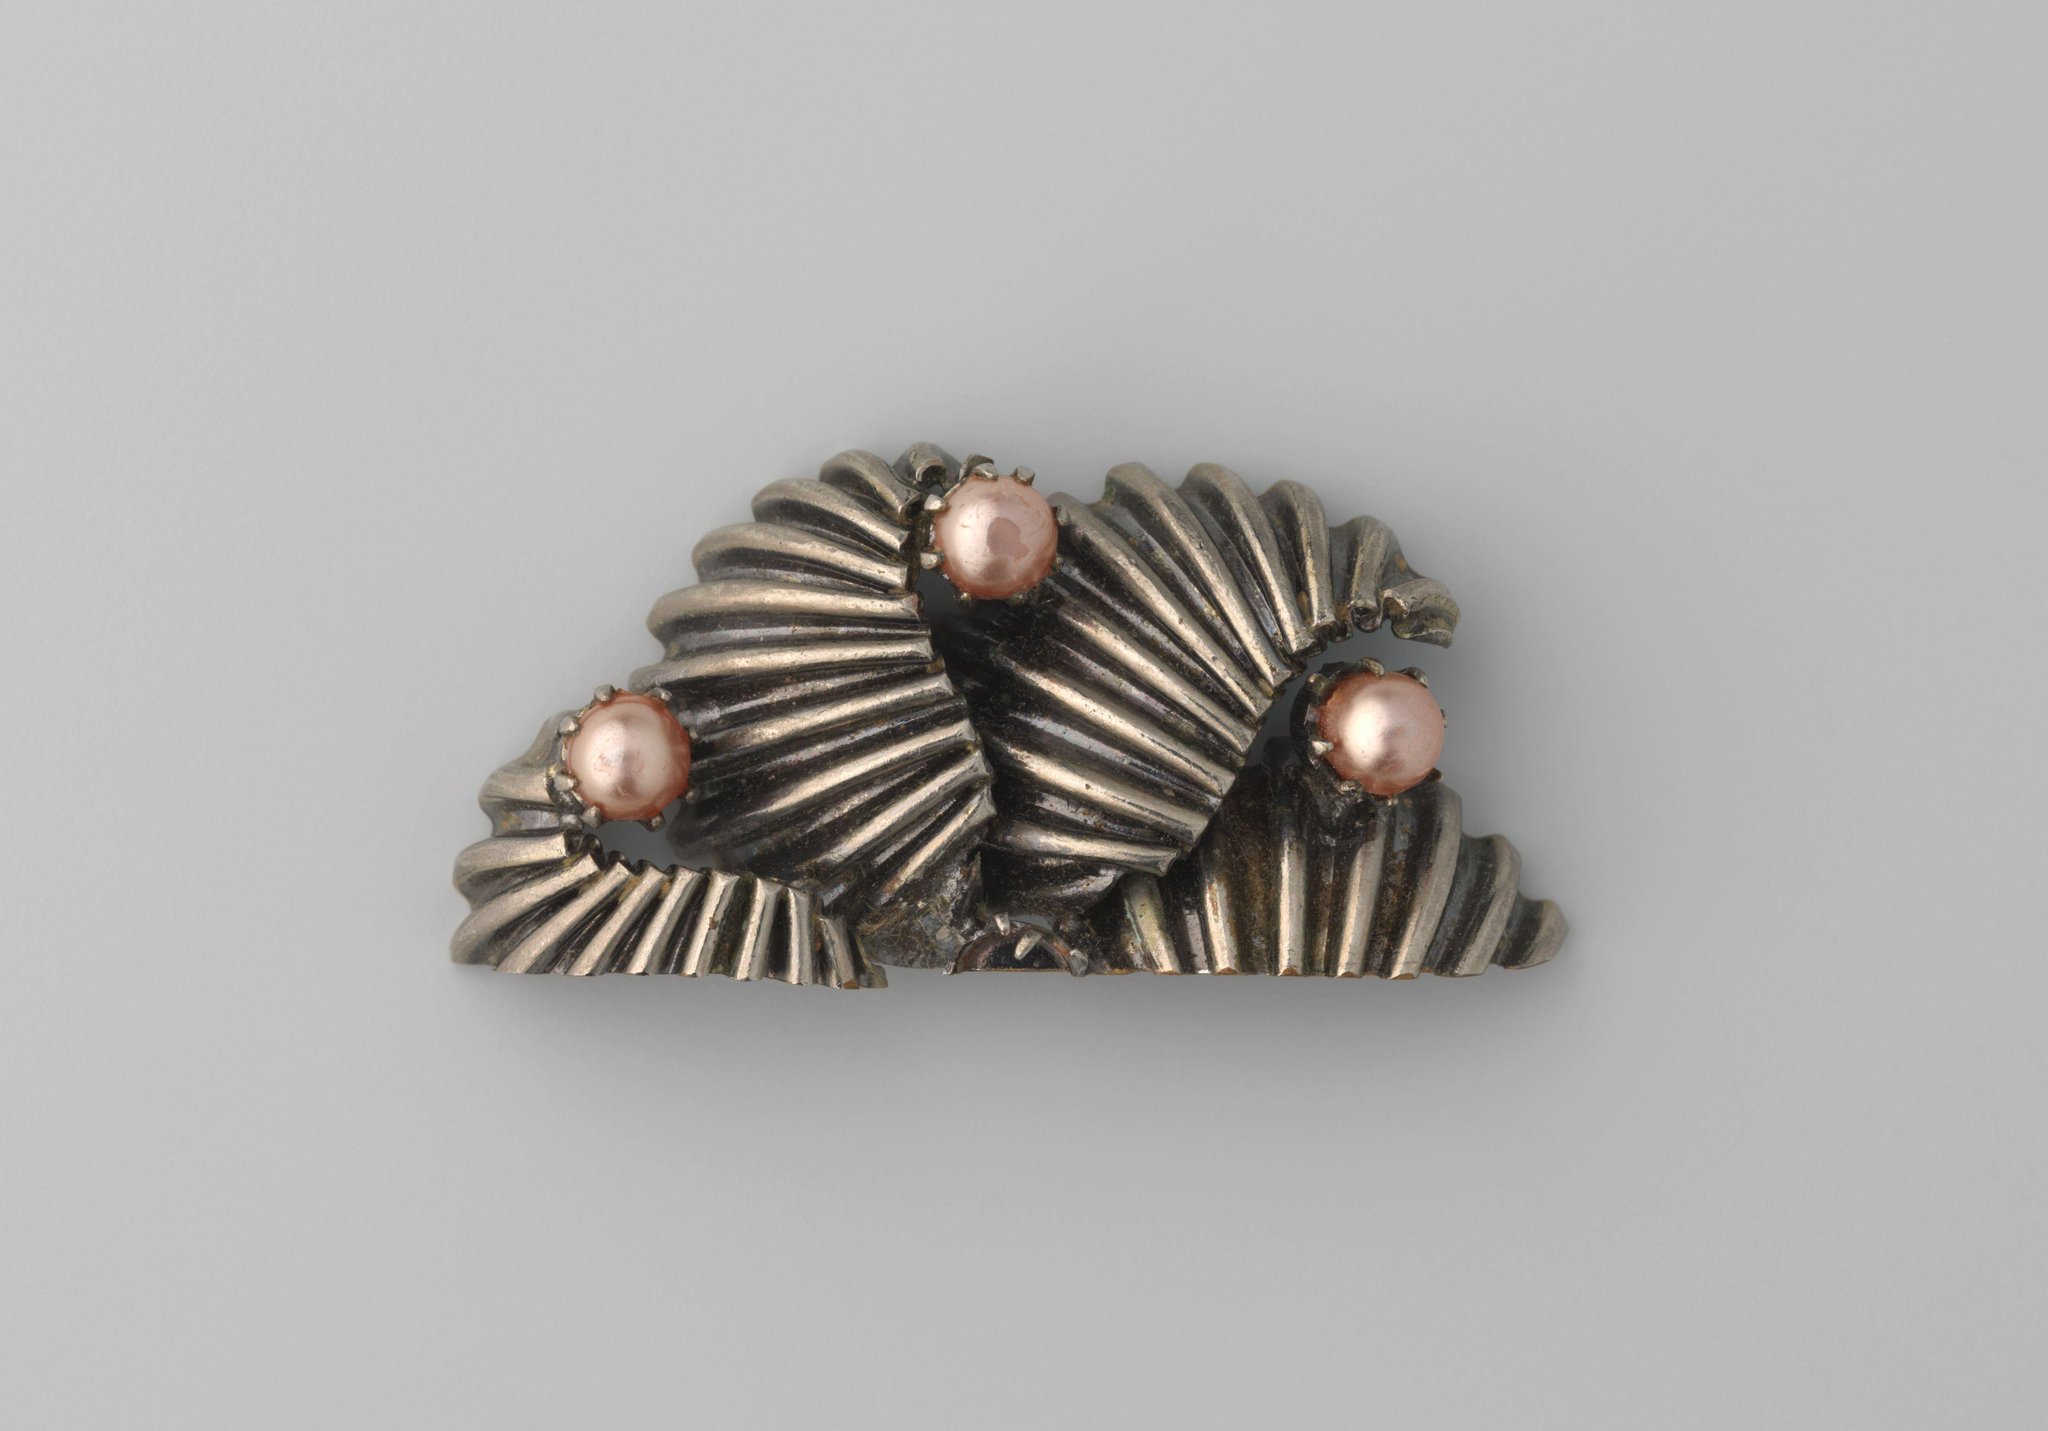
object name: fragment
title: Helft van een doorgezaagde draadbroche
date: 1998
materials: pearl, metal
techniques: sawing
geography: bussum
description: Helft van een doorgezaagde draadbroche met drie imitatieparels; de andere helft van de broche is verwerkt in een hanger samengesteld uit doorgezaagde sieraden aan koordketting van zilver. De doorgezaagde sieraden zijn afkomstig van de moeder van Marjan Unger.